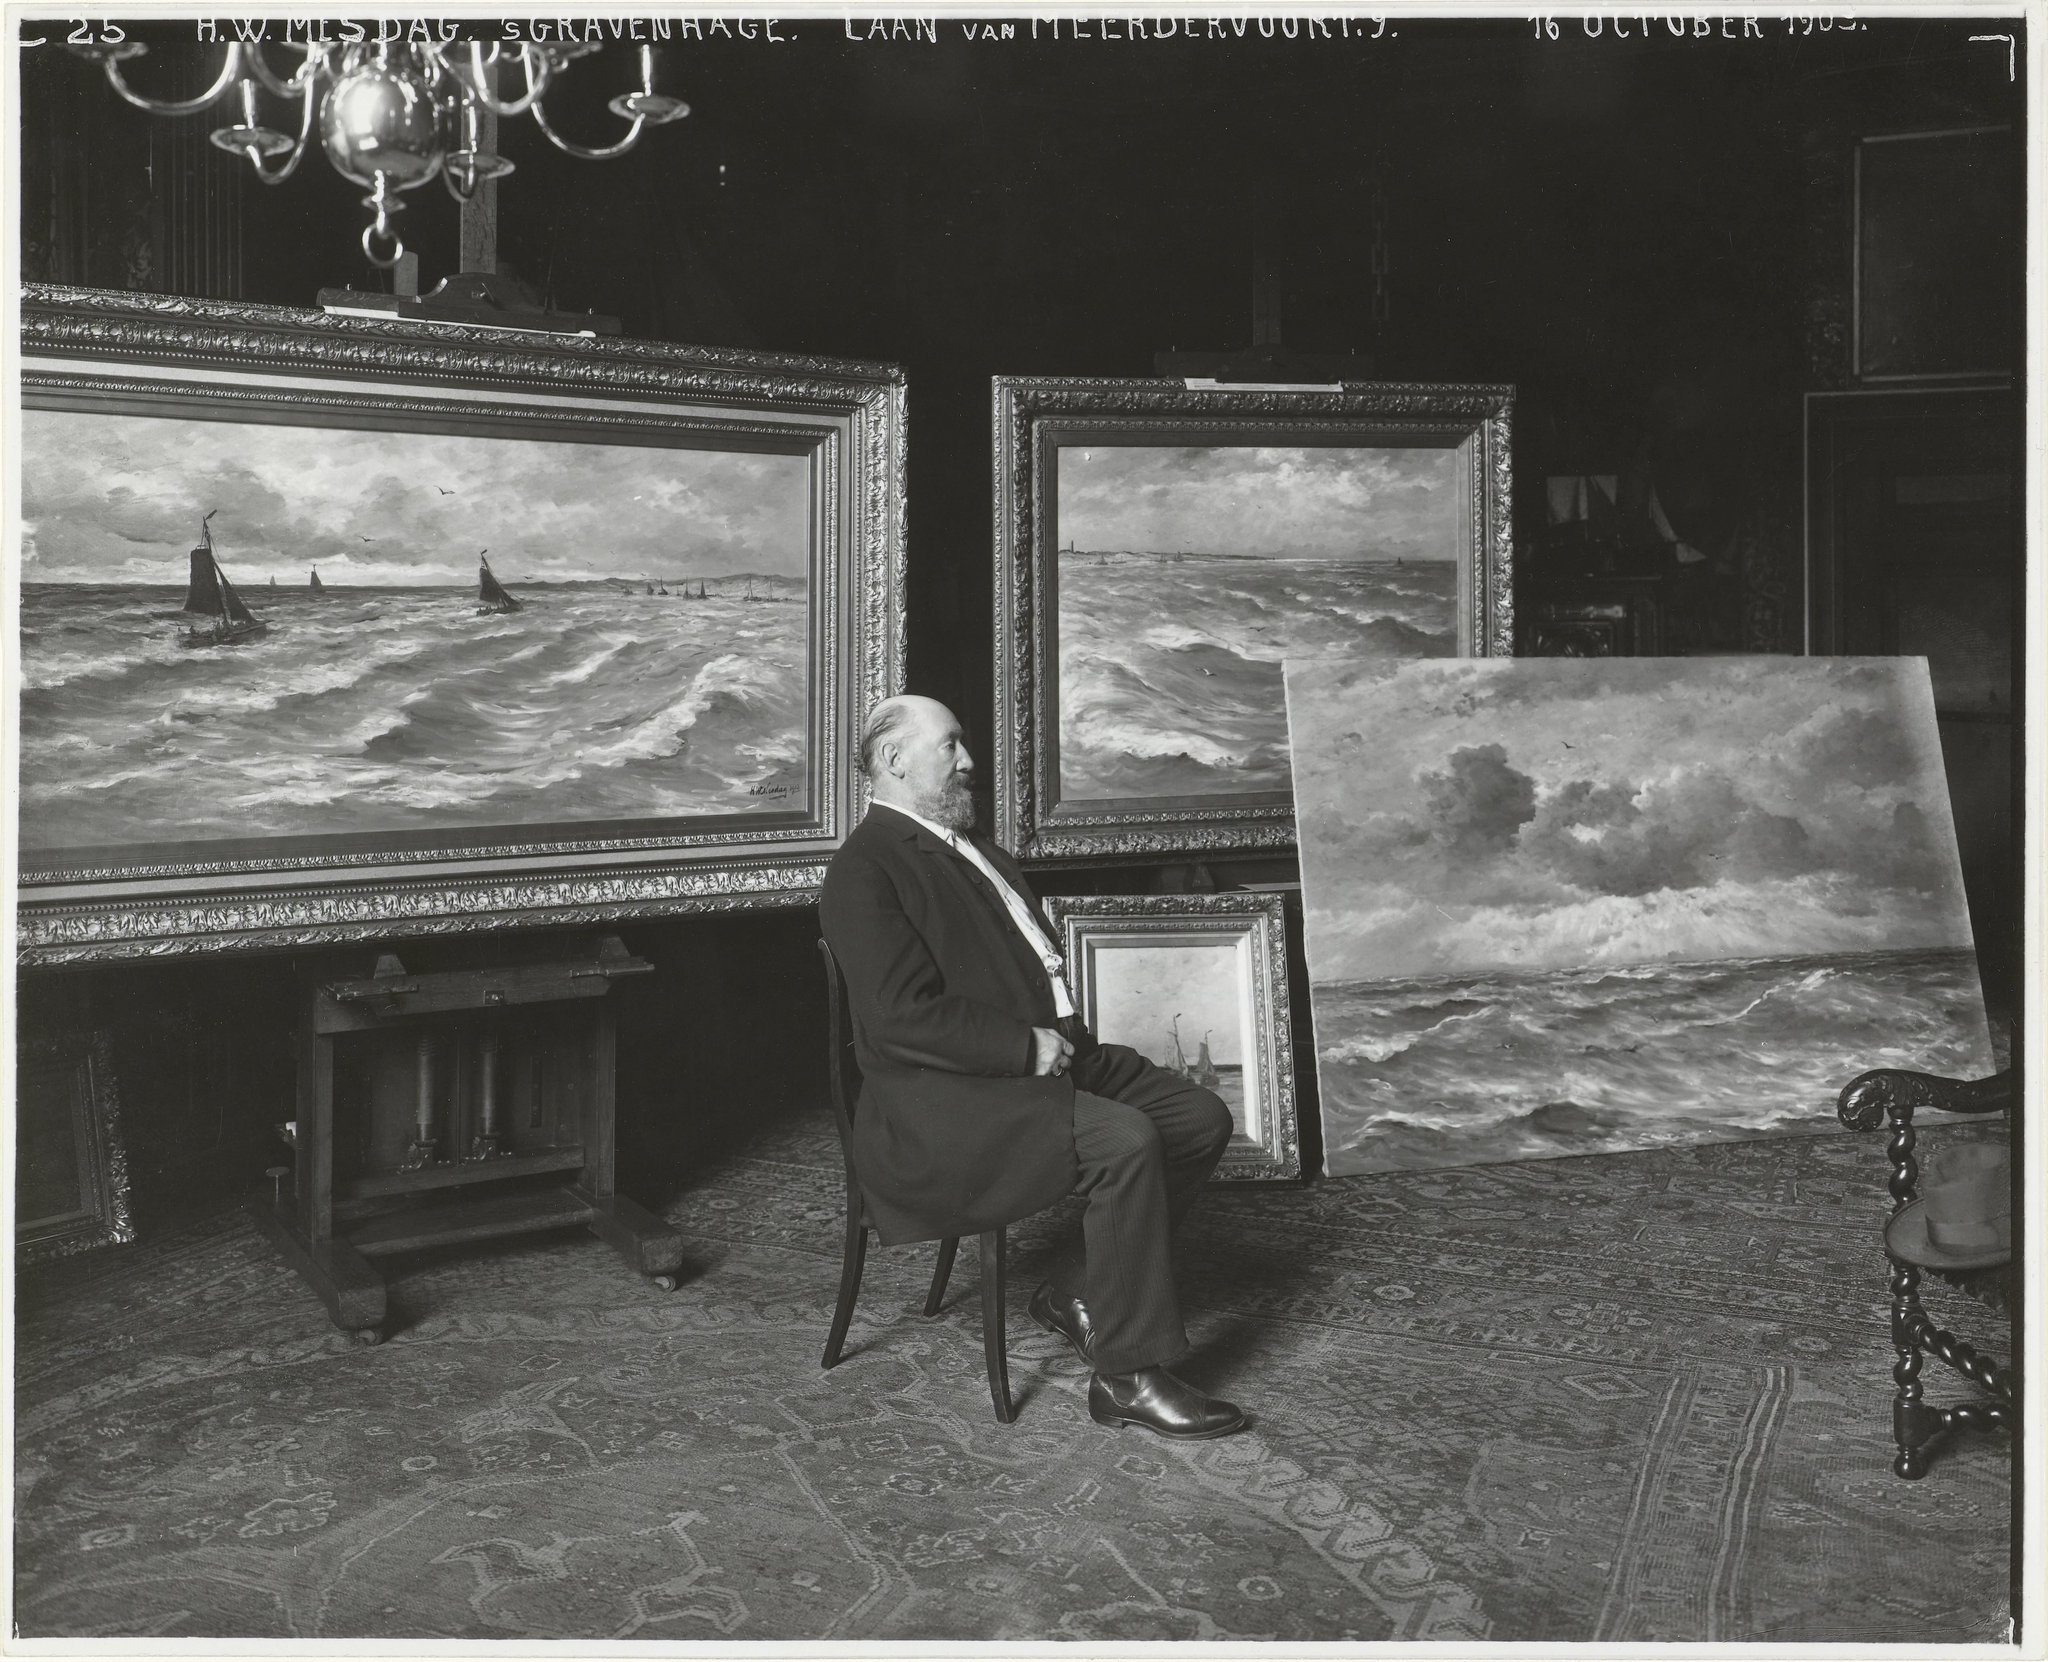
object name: photograph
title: De schilder Hendrik Willem Mesdag in zijn atelier, Laan van Meerdervoort 9, Den Haag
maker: sigmund löw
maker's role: publisher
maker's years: 1845-1920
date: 1903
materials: photographic support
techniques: gelatin silver print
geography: amsterdam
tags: painter at work, in his studio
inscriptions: stamp: ‘WORLD / COPYRIGHT / by W. M. A. DEPPE, / Bachlaan, 1 / NAARDEN (Holland) / TELEF. K 2959-55-5’, annotation: ‘25 H.W.MESDAG, s'GRAVENHAGE. LAAN VAN MEERDERVOORT.9 16 OCTOBER 1903.’